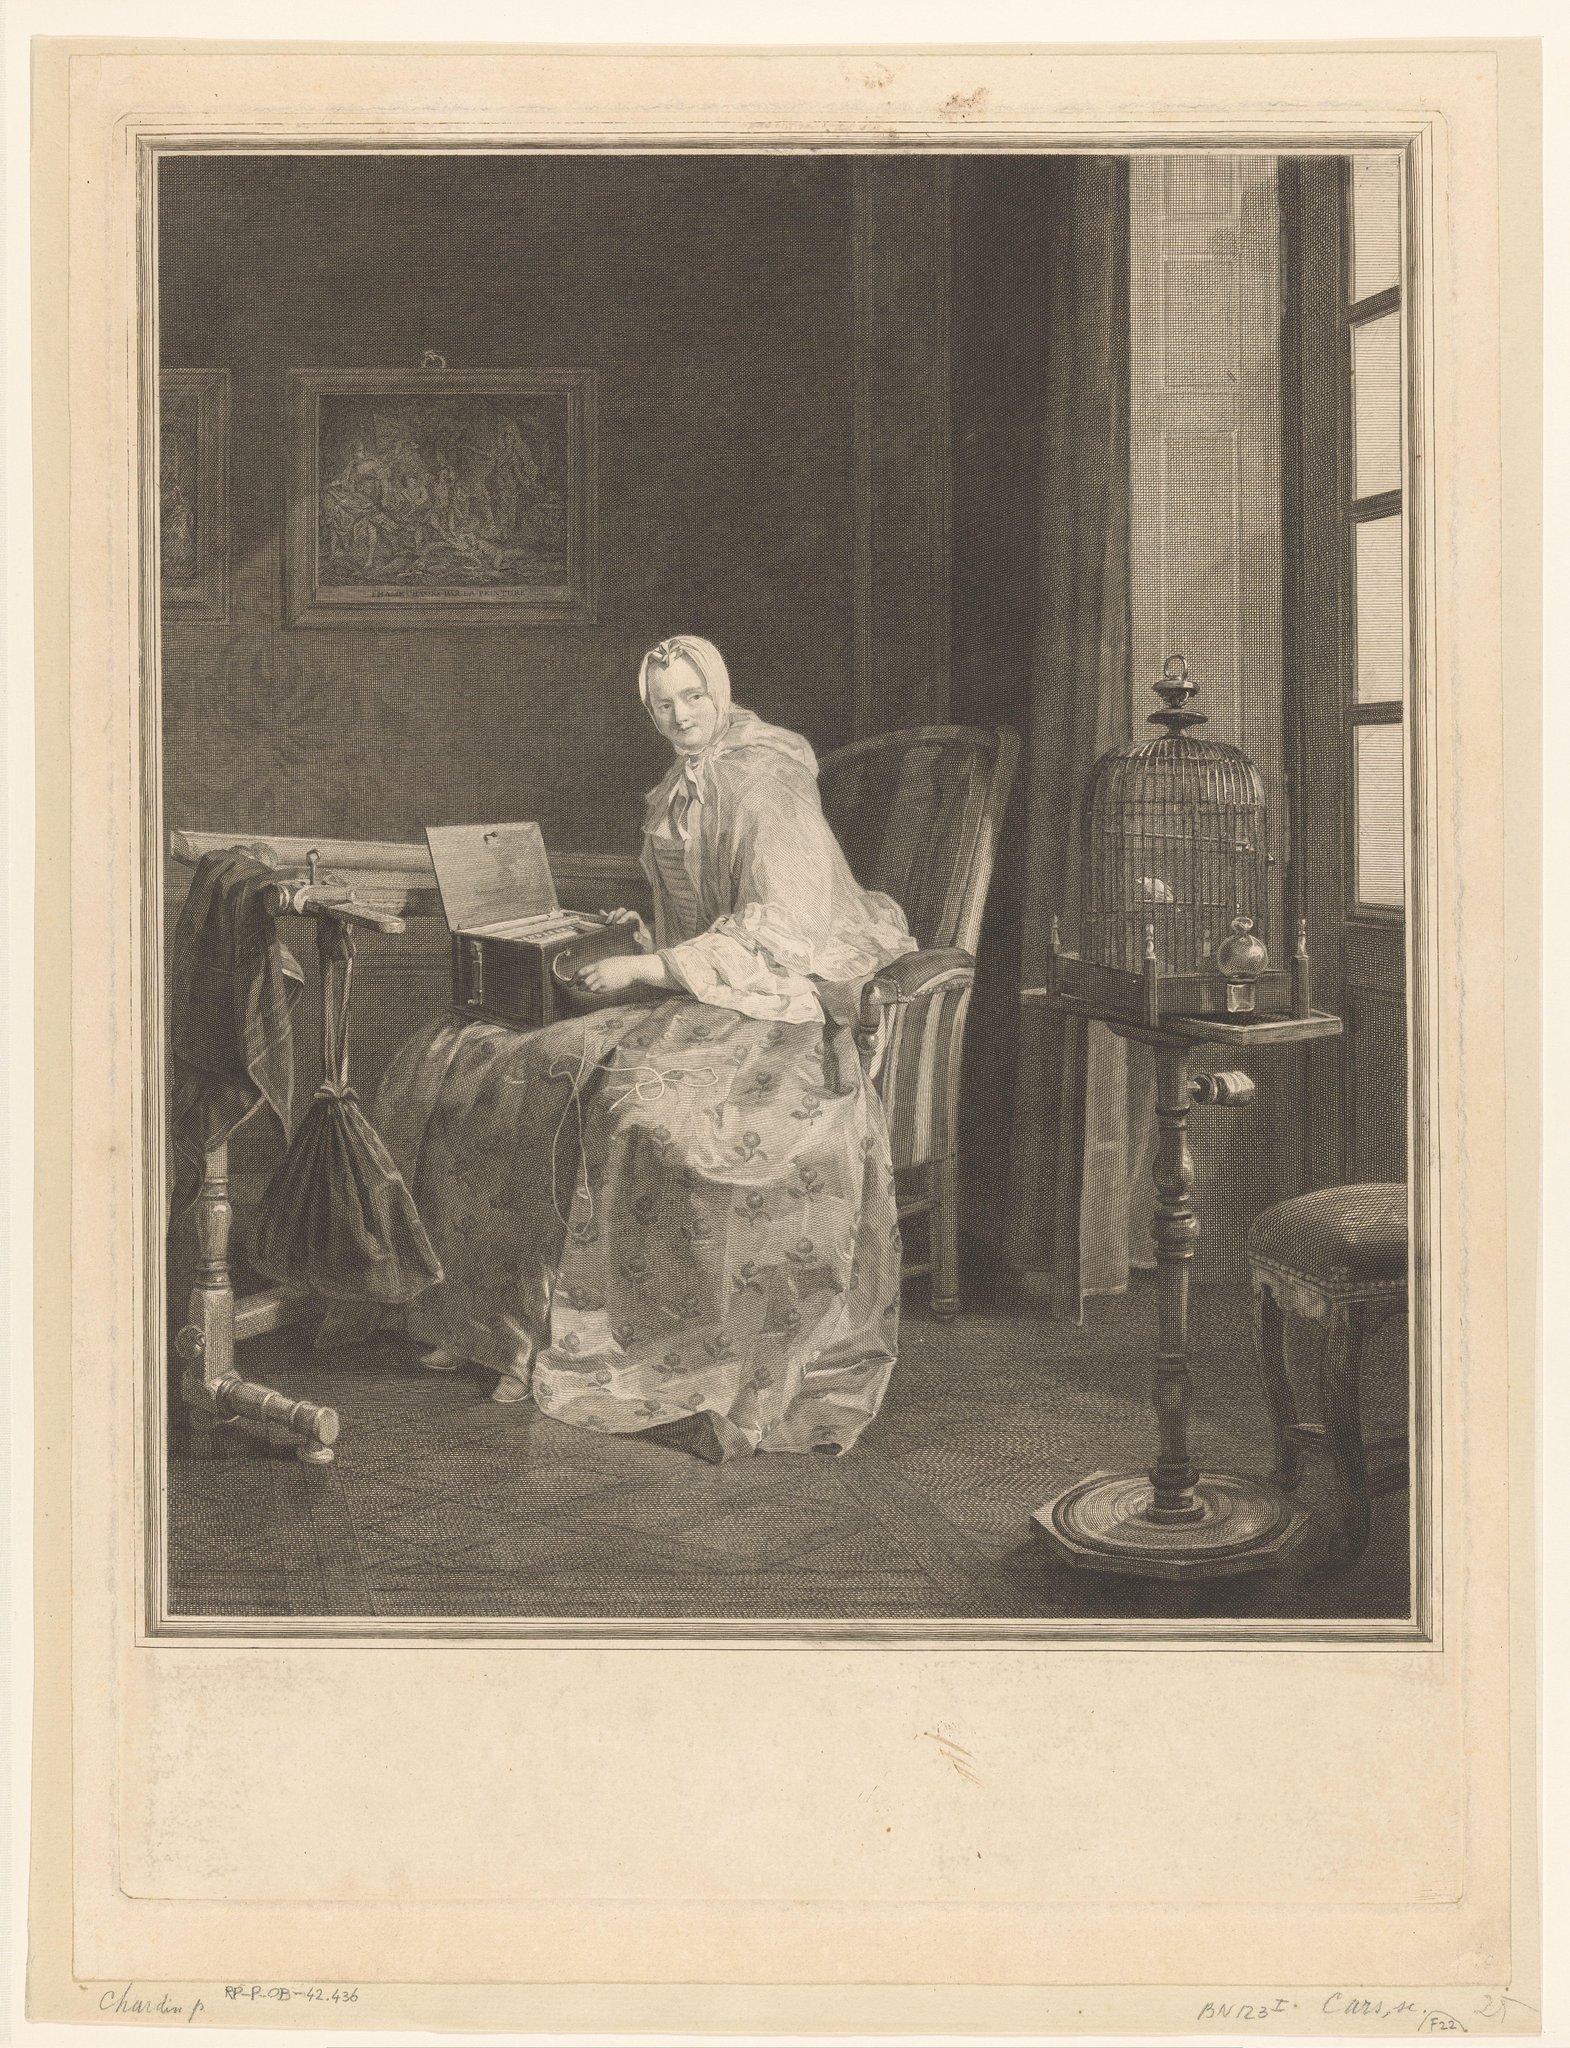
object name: print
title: Vrouw in een interieur met een draaiorgel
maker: laurent cars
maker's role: print maker, publisher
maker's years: 1699-1771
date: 1753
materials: paper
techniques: engraving, etching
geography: france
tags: hurdy-gurdy, barrel-organ player, interior of the house, dress, gown, bird in a cage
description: De prent, ook wel La Serinette genoemd, werd door Cars tentoongesteld op de Salon van 1753, p. 29. Het schilderij door Chardin werd in 1751 voor de koning geschilderd en bevindt zich sinds 1926 in de The Frick Collection, New York, inv.nr. 1926.1.22.